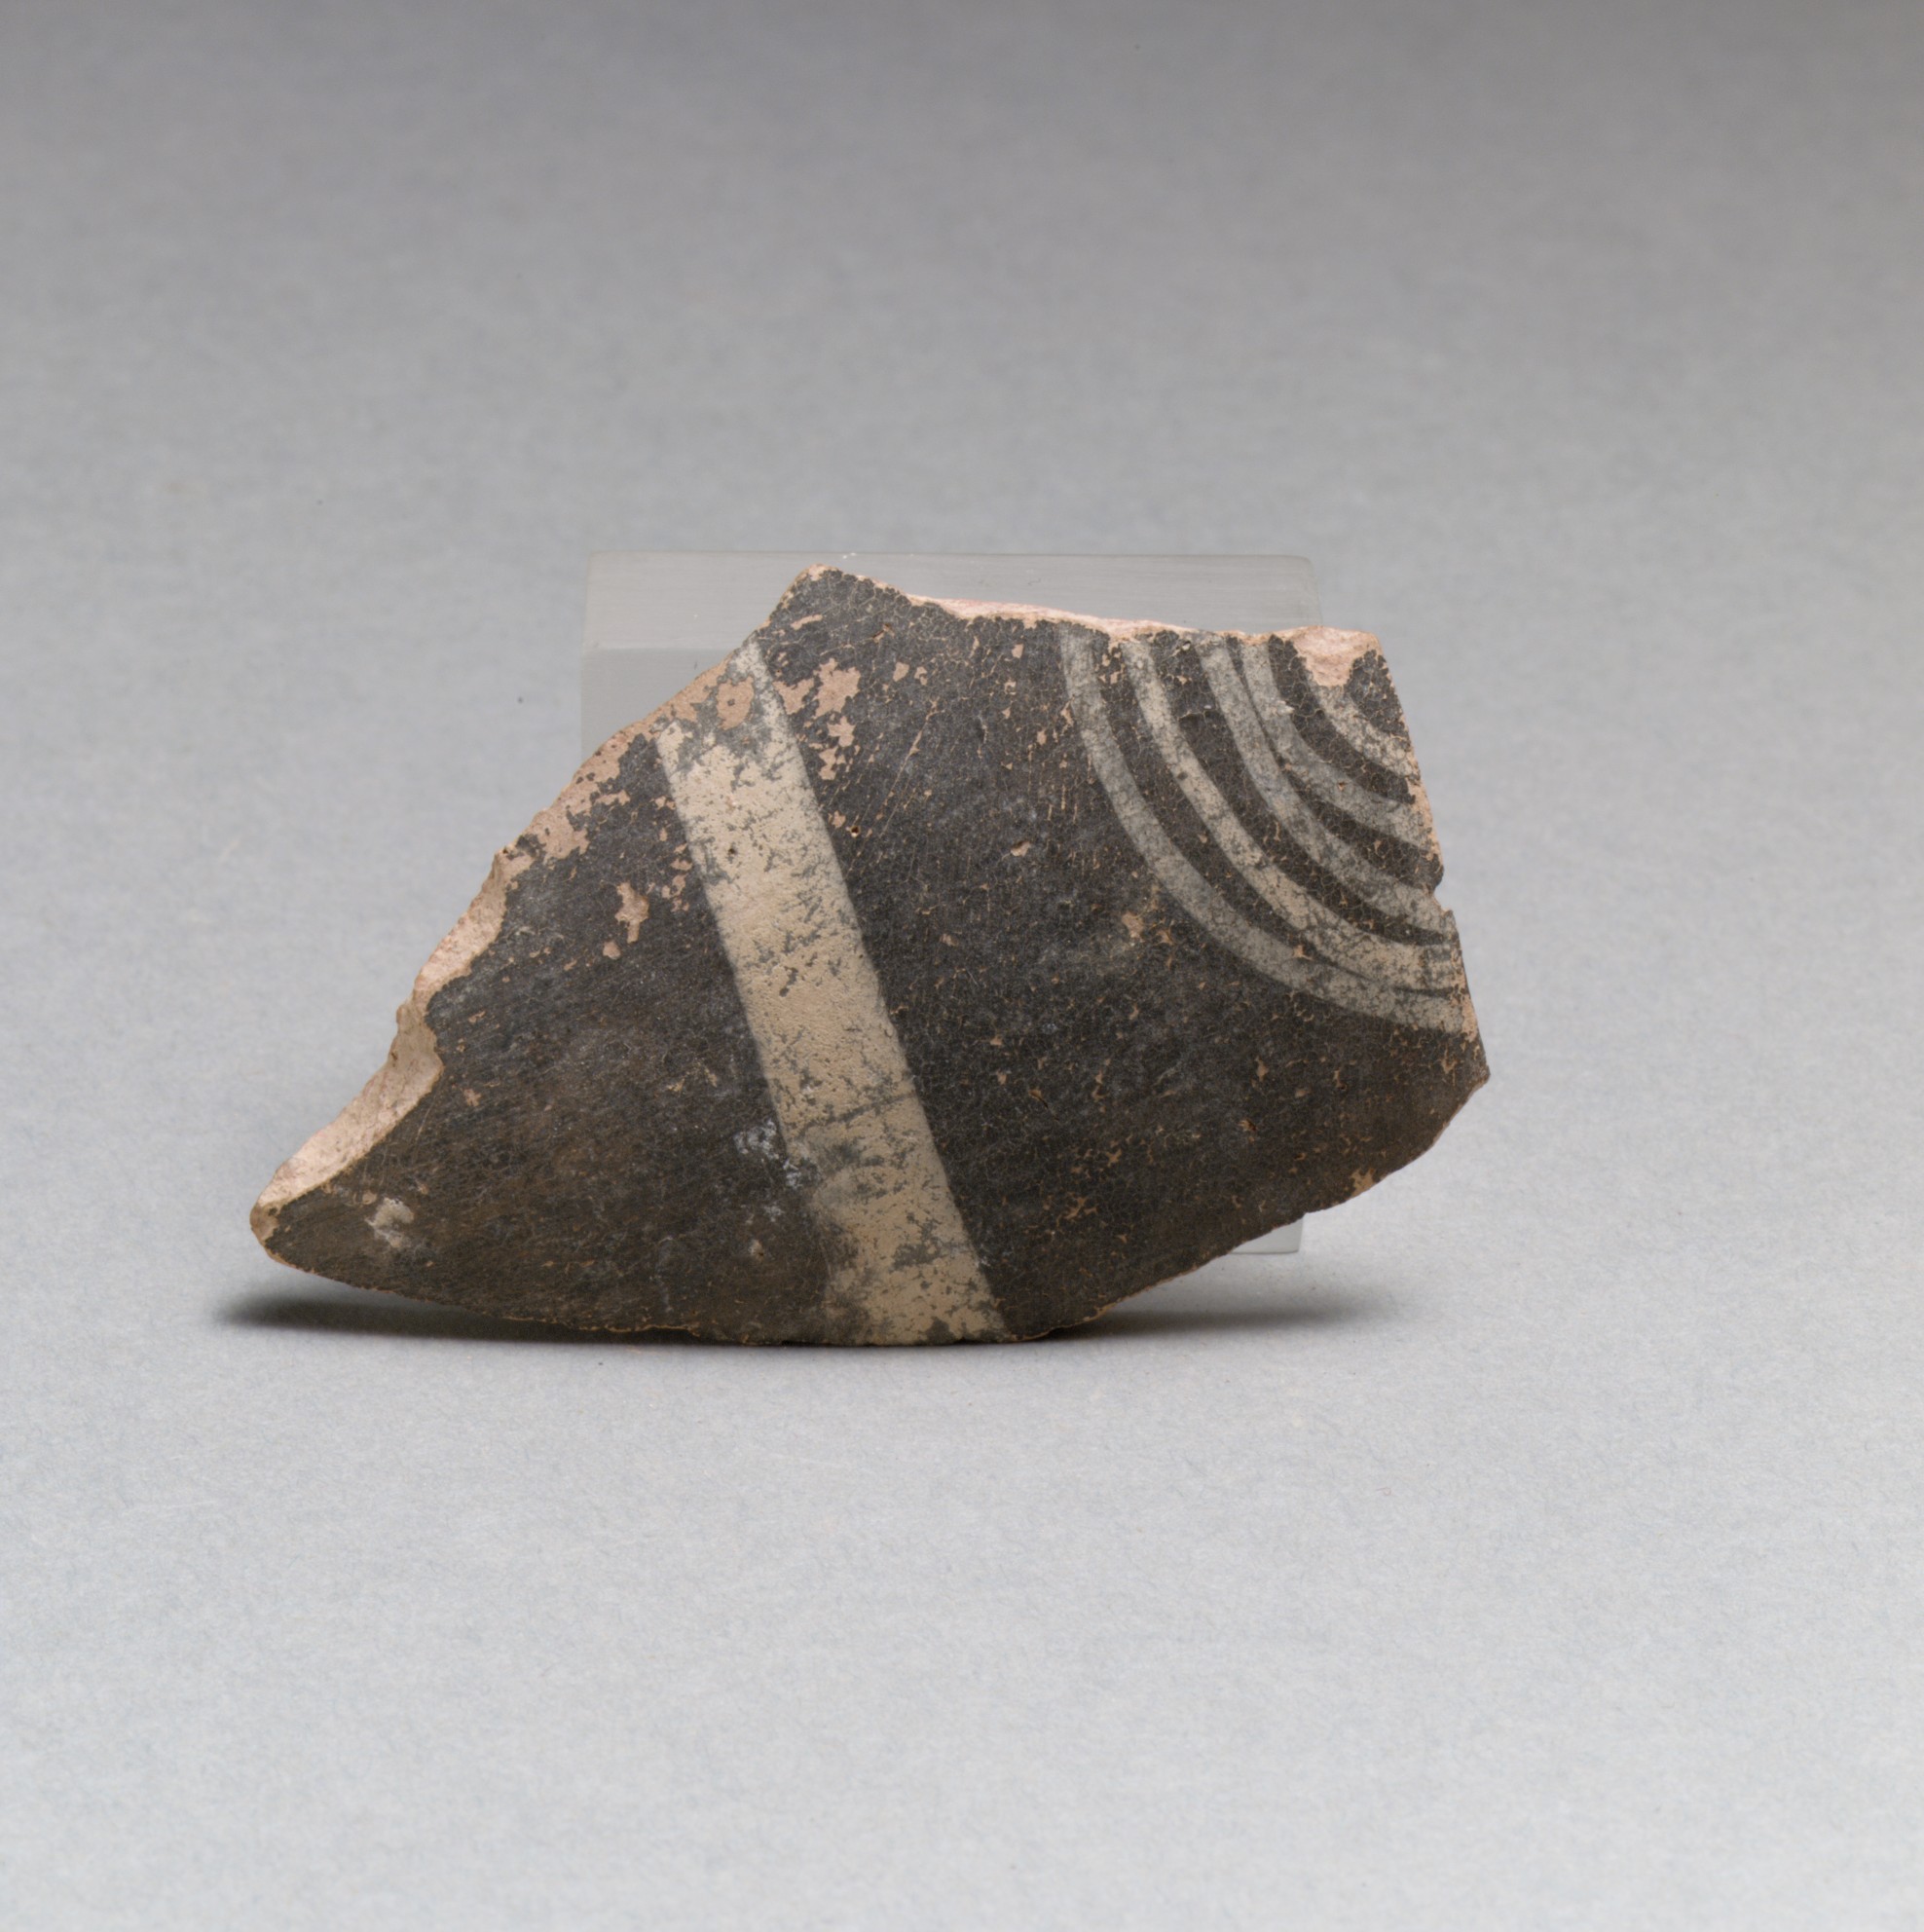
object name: vase fragment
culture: minoan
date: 2600-2000 BCE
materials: terracotta